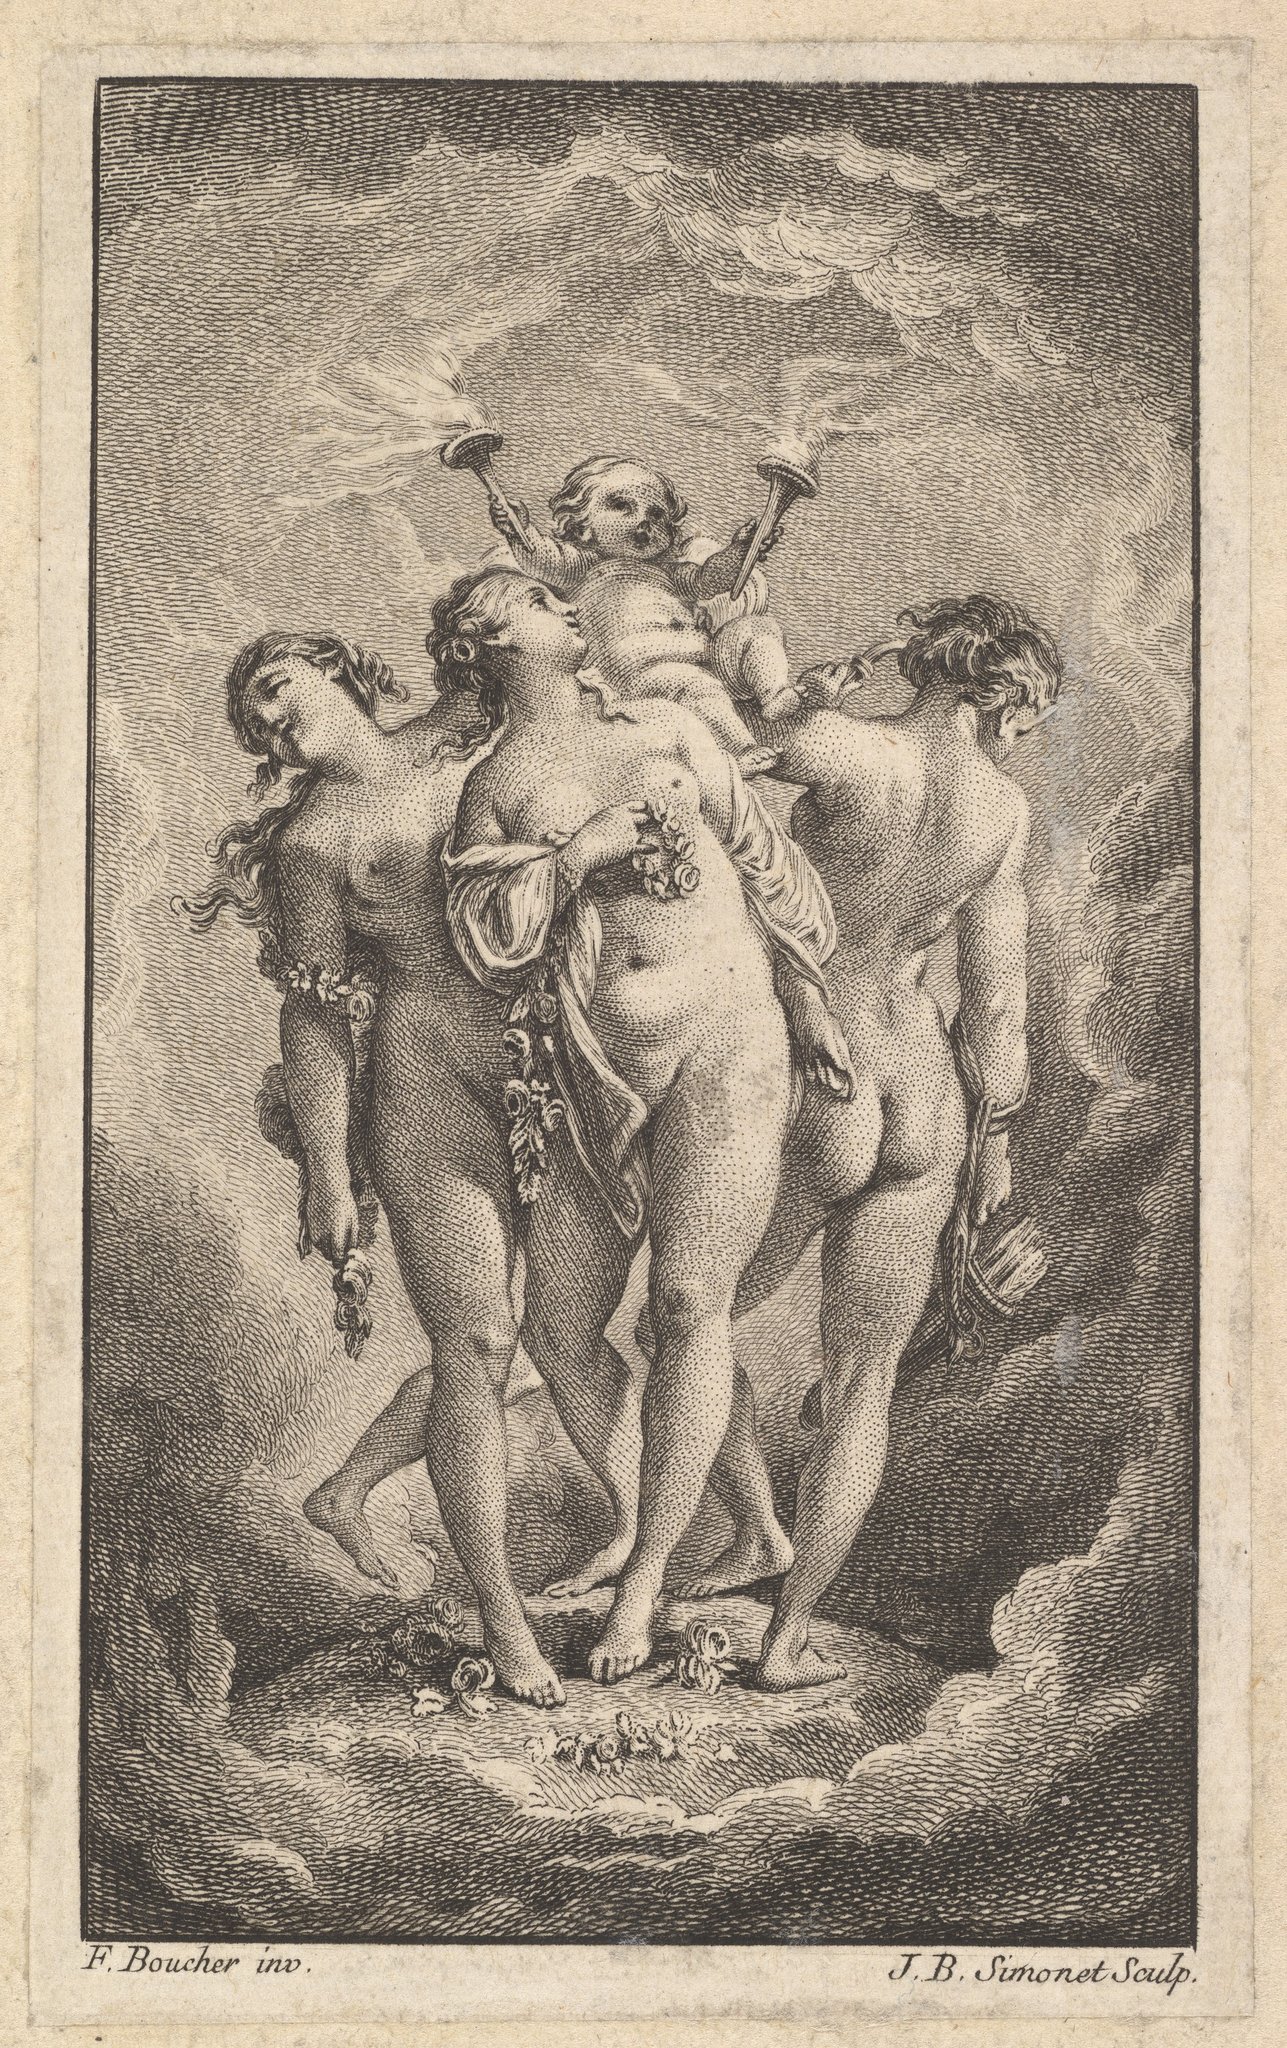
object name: print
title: The triumph of the Graces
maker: jean-baptiste-blaise simonet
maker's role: artist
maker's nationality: french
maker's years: 1742-1842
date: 1742-1813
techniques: engraving, etching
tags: female nudes